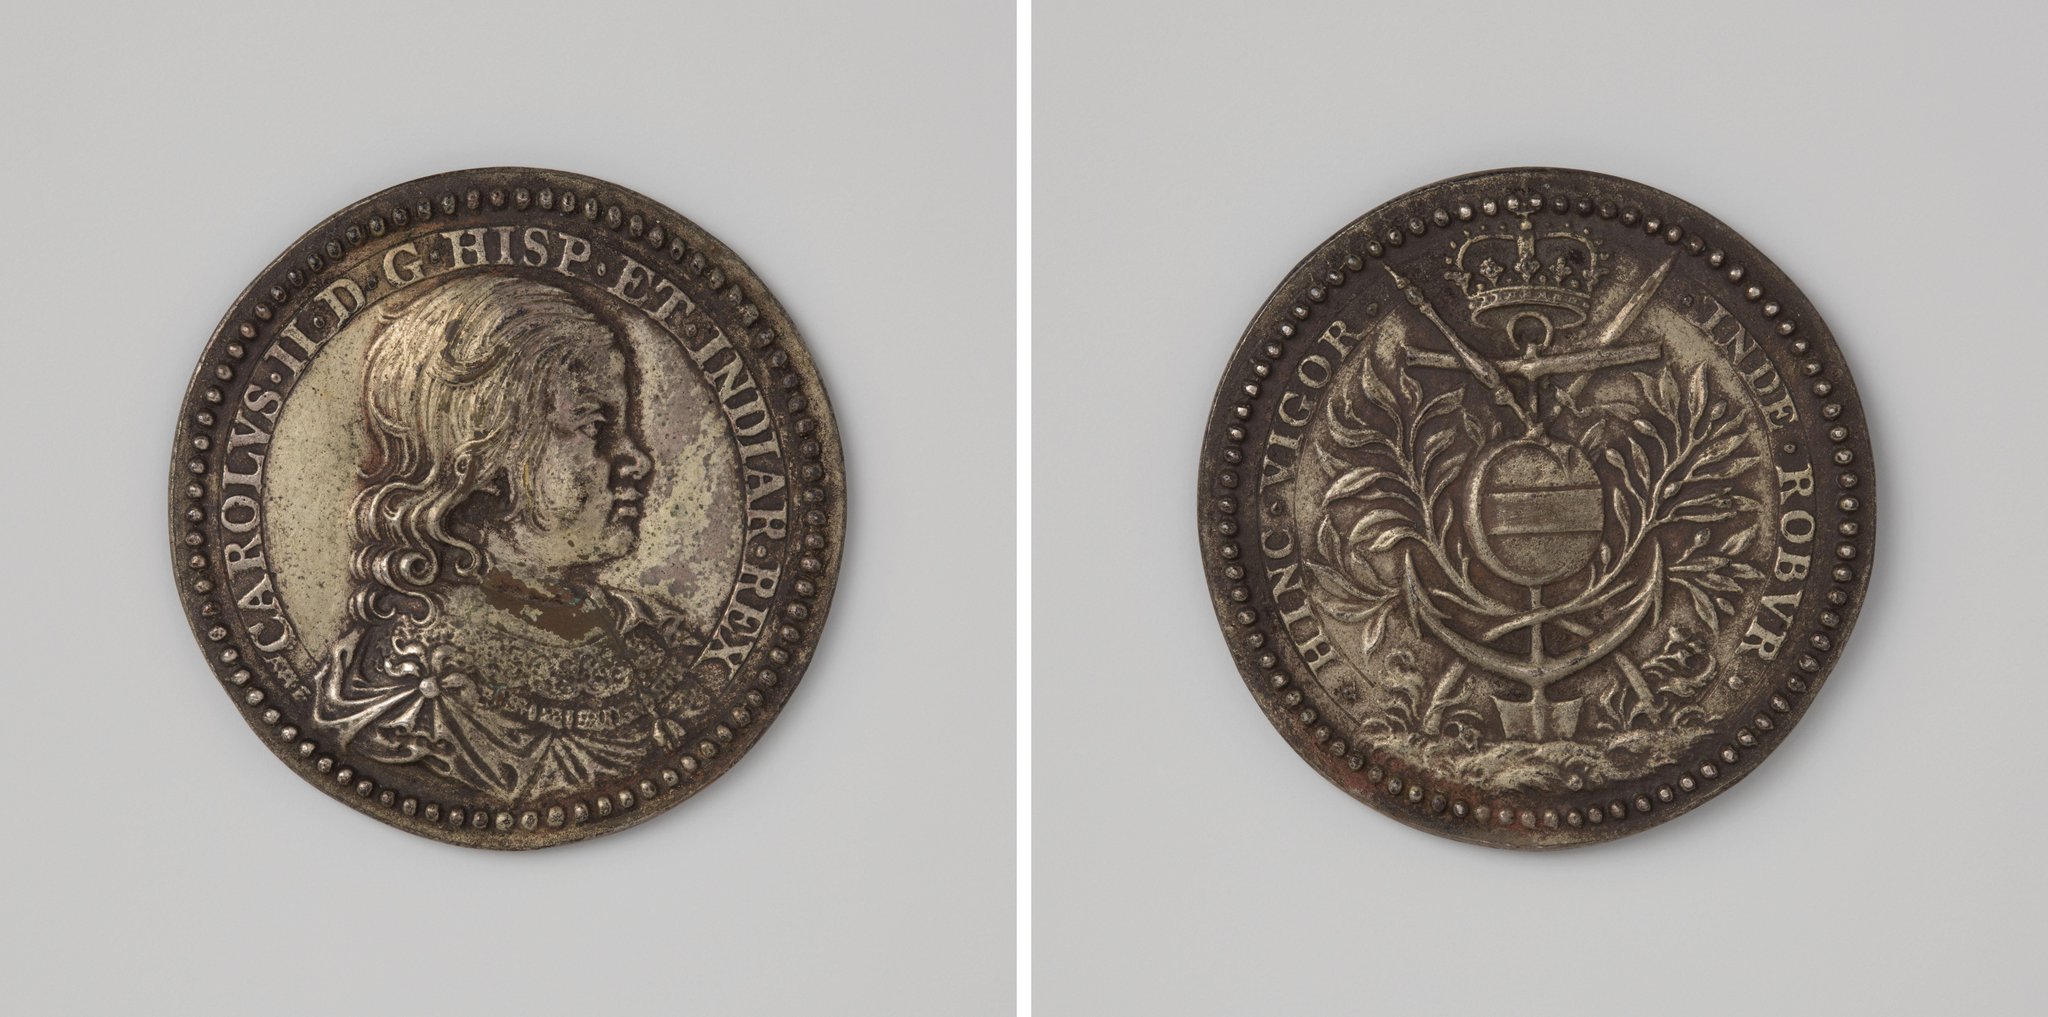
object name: history medal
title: Vrede van Aken, ter ere van Karel II, koning van Spanje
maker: adriaan waterloos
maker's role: medailleur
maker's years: 1600-1684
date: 1668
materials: silver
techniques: casting, gilding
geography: brussels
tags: karel ii (koning van spanje), spain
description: Zilveren penning. Voorzijde: borststuk jongeman (Karel II) binnen omschrift. Keerzijde: gekroond wapenschild tussen scepter, degen, olijftakken, spade en anker binnen omschrift.